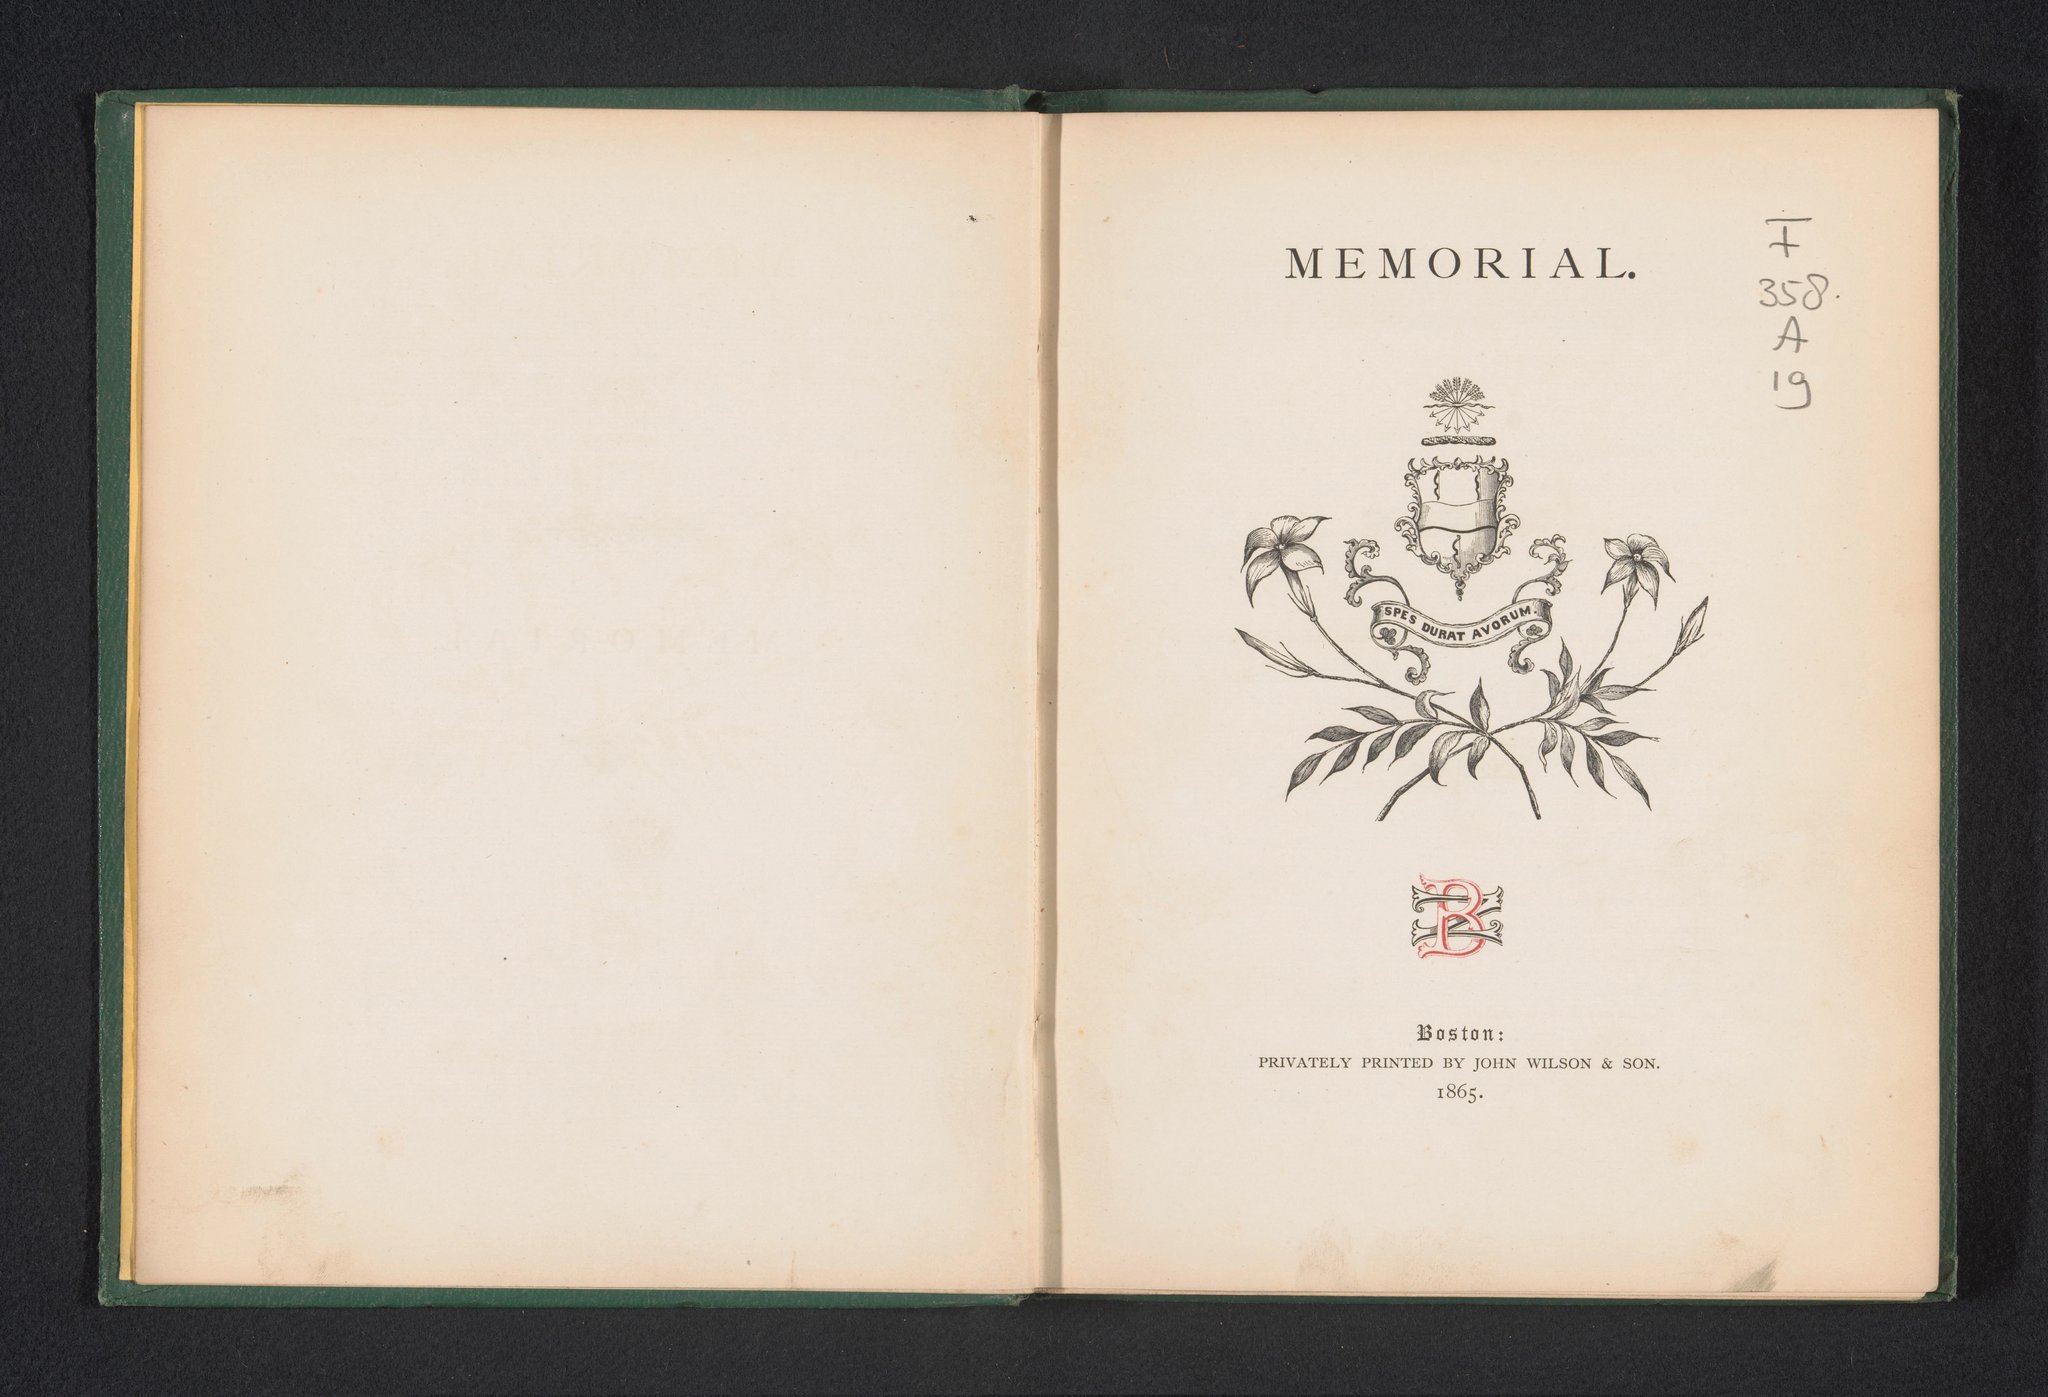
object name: book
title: Memorial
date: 1865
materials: cardboard, leather, paper, photographic support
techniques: albumen print, printing, engraving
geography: boston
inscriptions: annotation, annotation: ‘JUNE/ 1997’